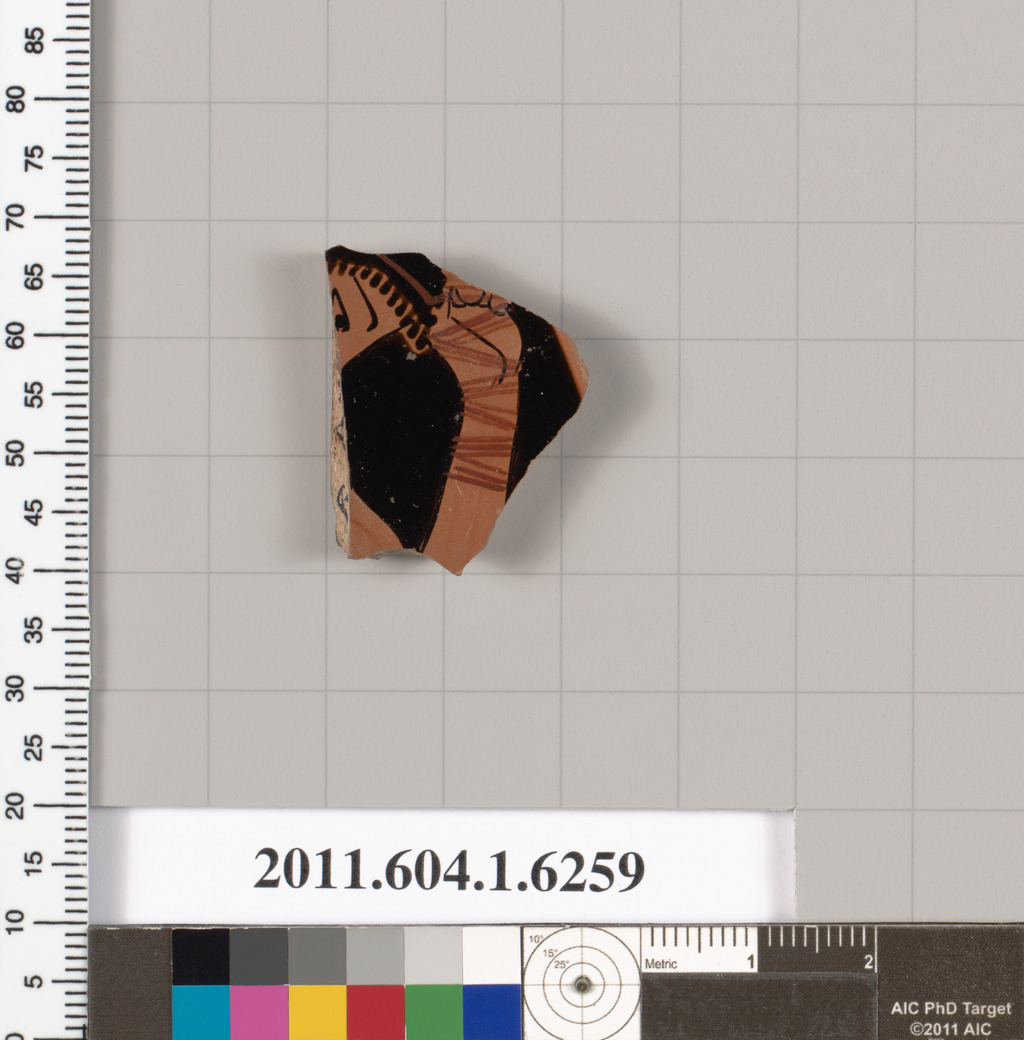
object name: kylix fragment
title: Terracotta fragment of a kylix (drinking cup)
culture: greek, attic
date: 500-480 BCE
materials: terracotta